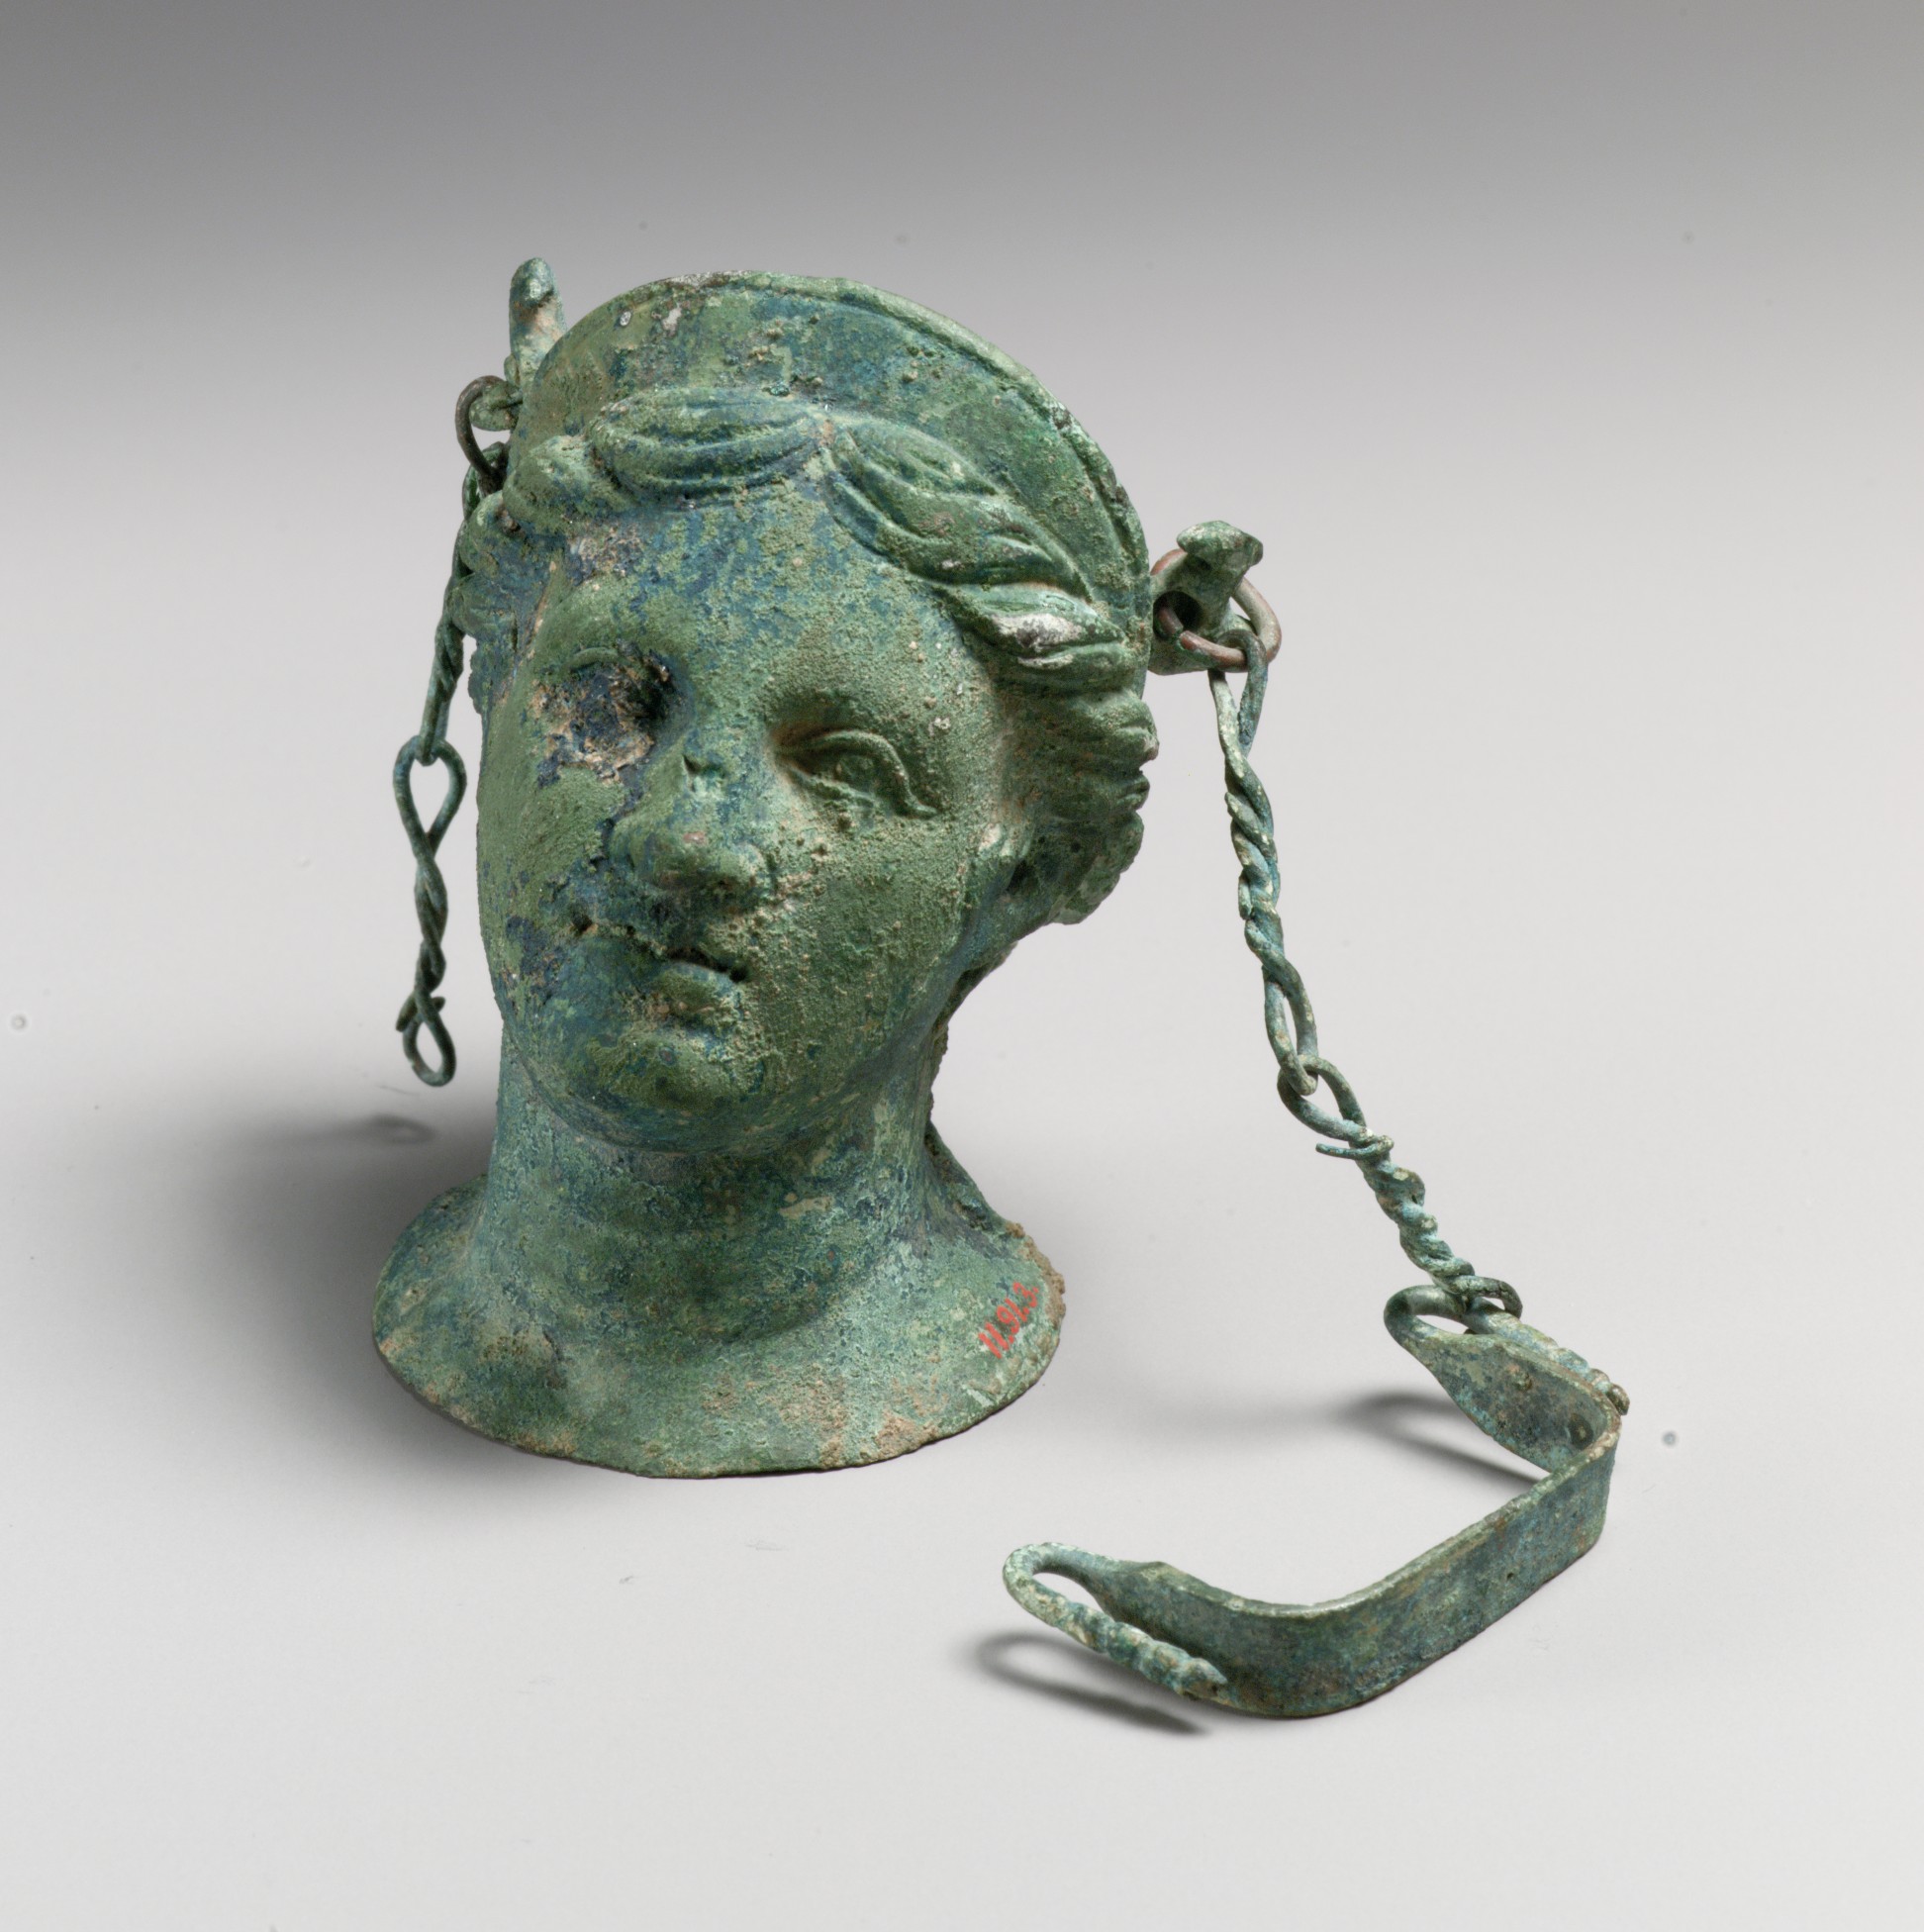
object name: head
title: Bronze balsamarium (cosmetics container)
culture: etruscan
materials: bronze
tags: heads,women